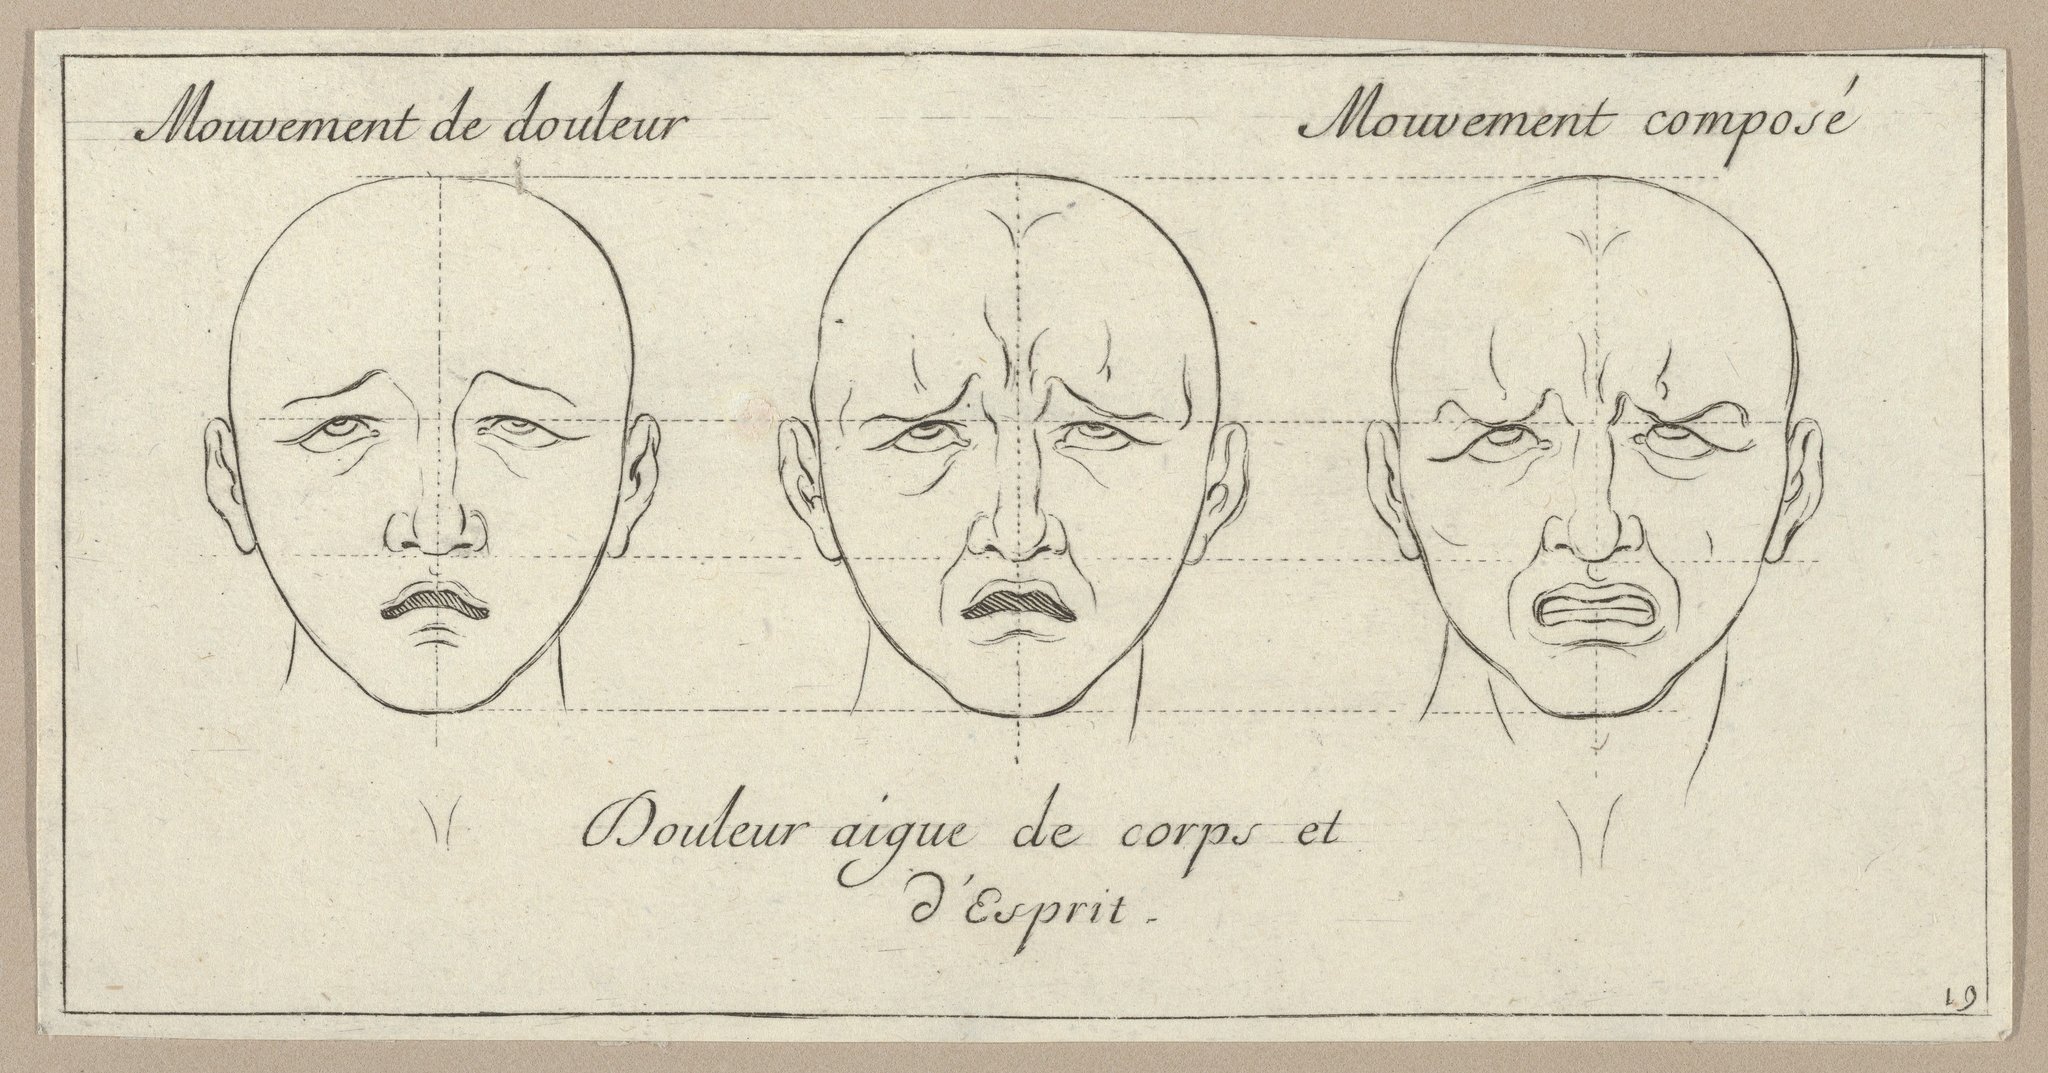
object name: print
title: Mouvement de douleur, Douleur aigue de corps et d'Esprit, Mouvement composé, from "Caractères des passions, gravés sur les desseins de l'illustre Monsieur le Brun"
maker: sébastien le clerc, le jeune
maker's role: etcher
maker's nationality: french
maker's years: 1676-1763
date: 1695-1720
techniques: etching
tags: heads,men